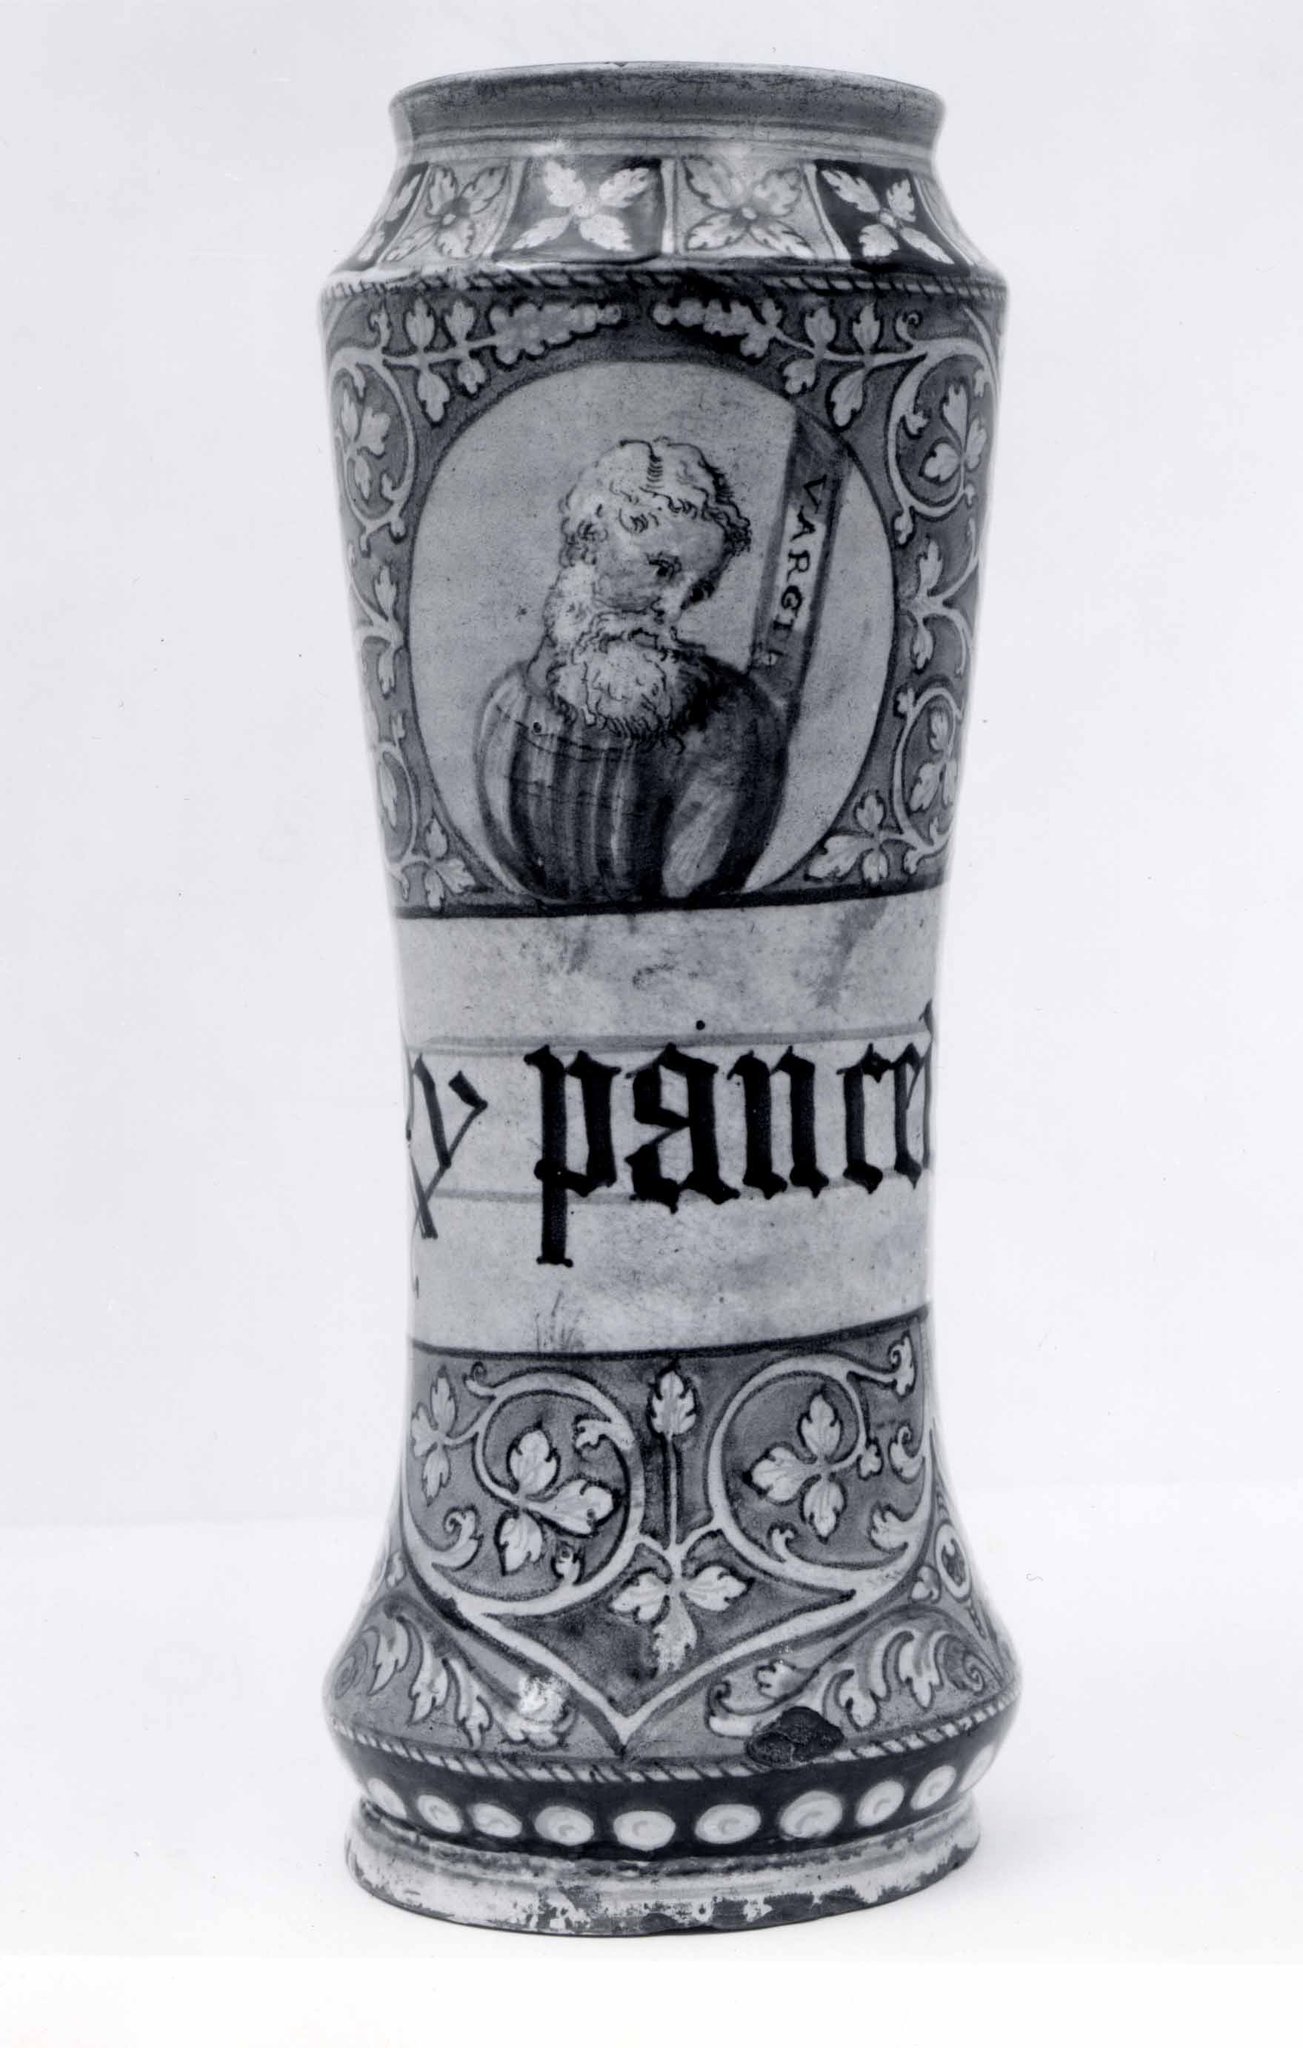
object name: albarello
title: Apothecary jar (albarello)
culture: italian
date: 1550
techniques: maiolica, glazing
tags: men